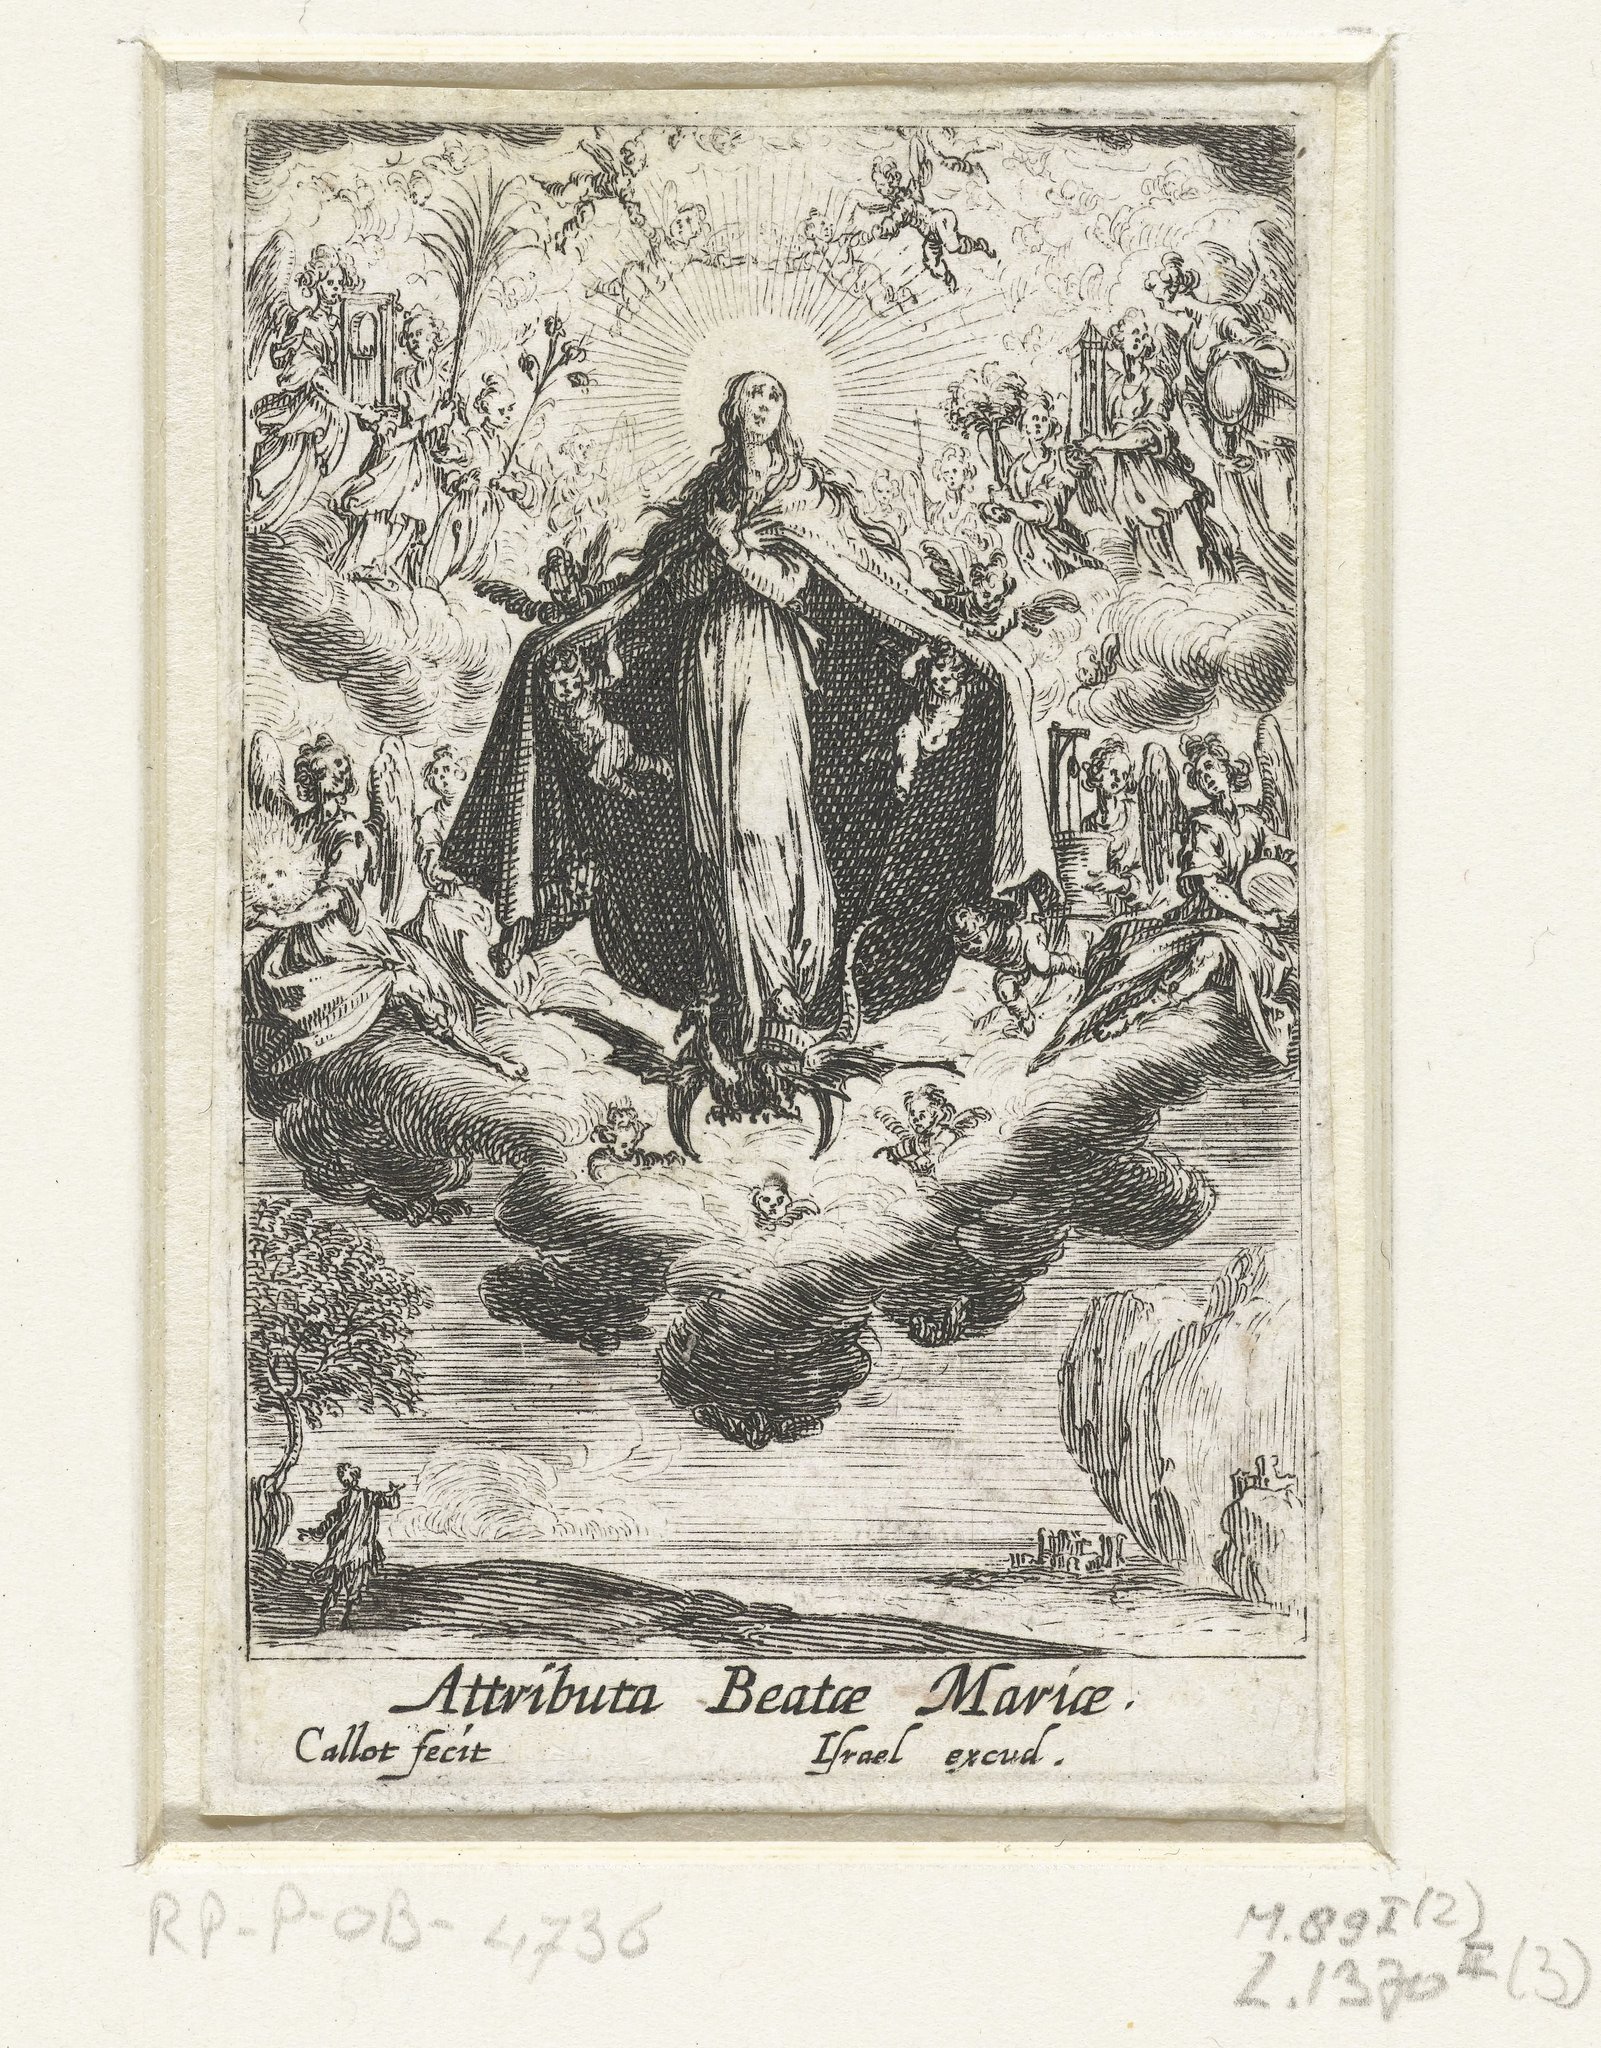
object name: print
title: Attributa Beatae Mariae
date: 1633-1634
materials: paper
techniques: etching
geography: paris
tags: 'immaculata', 'purisima': mary, usually standing on a crescent moon, descending from heaven, exempt from original sin (sometimes trampling serpent)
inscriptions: collector's mark: Lugt 240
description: Maria, staand in de lucht boven een landschap op een omgekeerde halve maan die op de rug van een monsterlijke vogel rust, te midden van engelen die objecten dragen (o.a. zon, maan, waterput, plant, palmtak, boom). Onder de voorstelling een onderschrift in Latijn. Deze prent is onderdeel van een reeks prenten rond het leven van Maria, bestaande uit een titelprent en dertien verhalende voorstellingen.